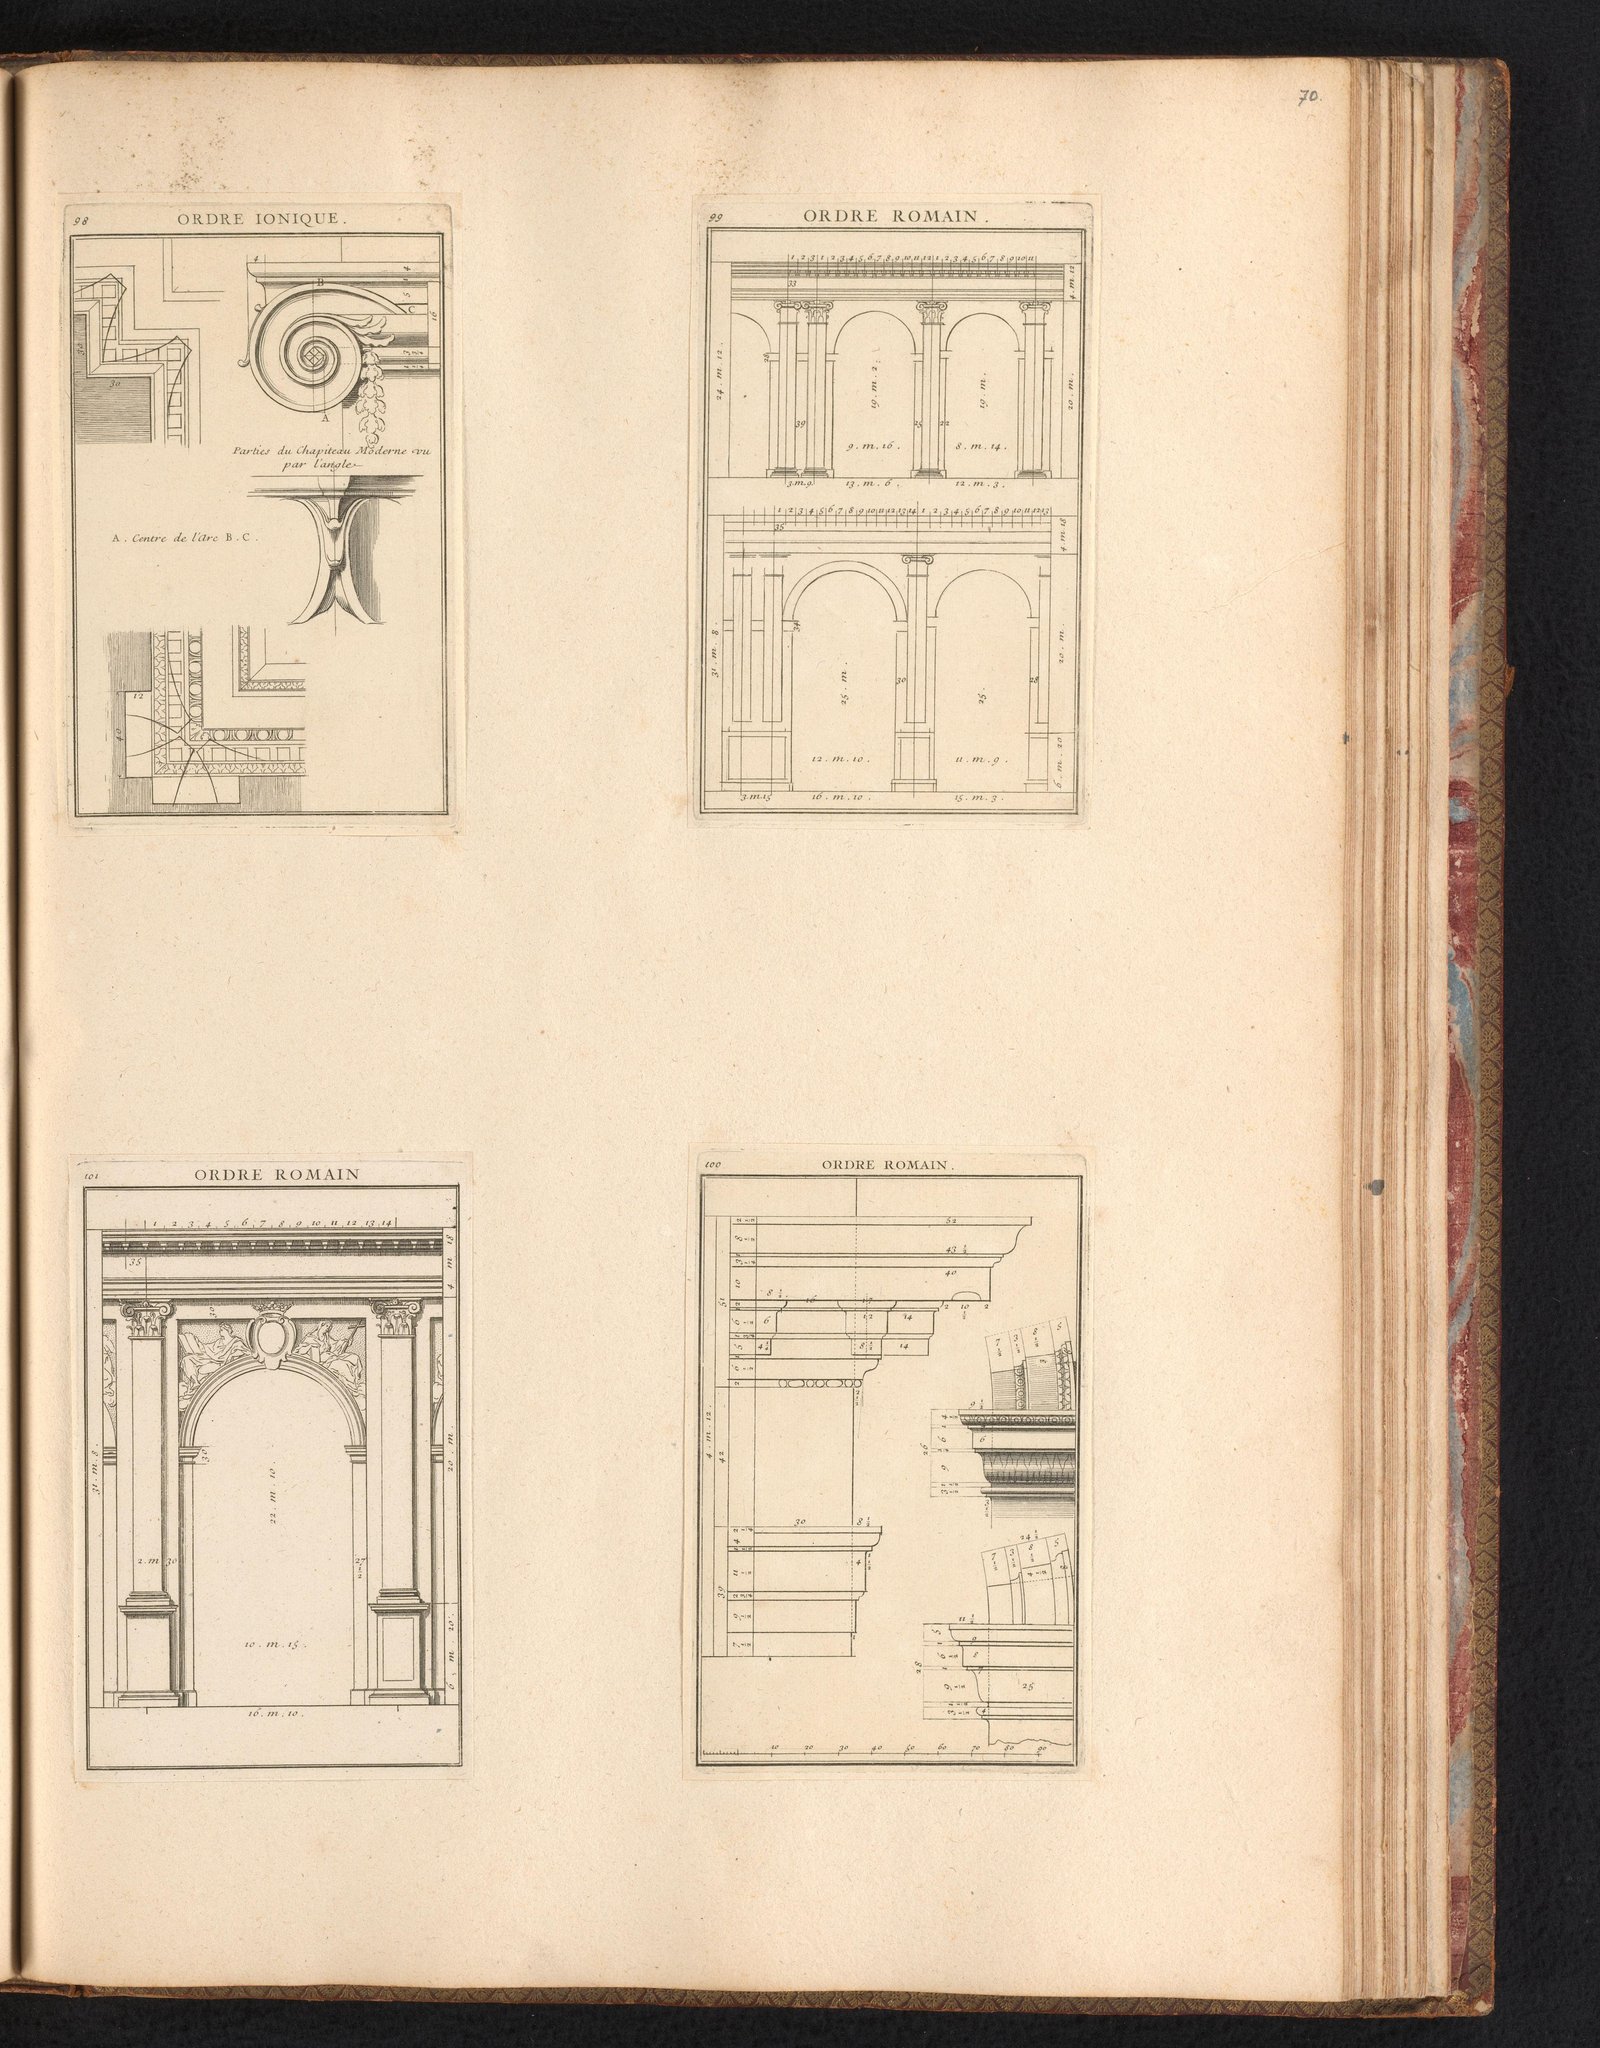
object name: album leaf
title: Pilasters van de Ionische en Composiete orde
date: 1714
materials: paper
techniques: etching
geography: paris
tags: composite order ~ architecture, half-column, pilaster ~ architecture, ionic order ~ architecture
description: Prenten uit: Leclerc, Sébastien (I). Traité d'architecture. Parijs: Pierre François Giffart, 1714.